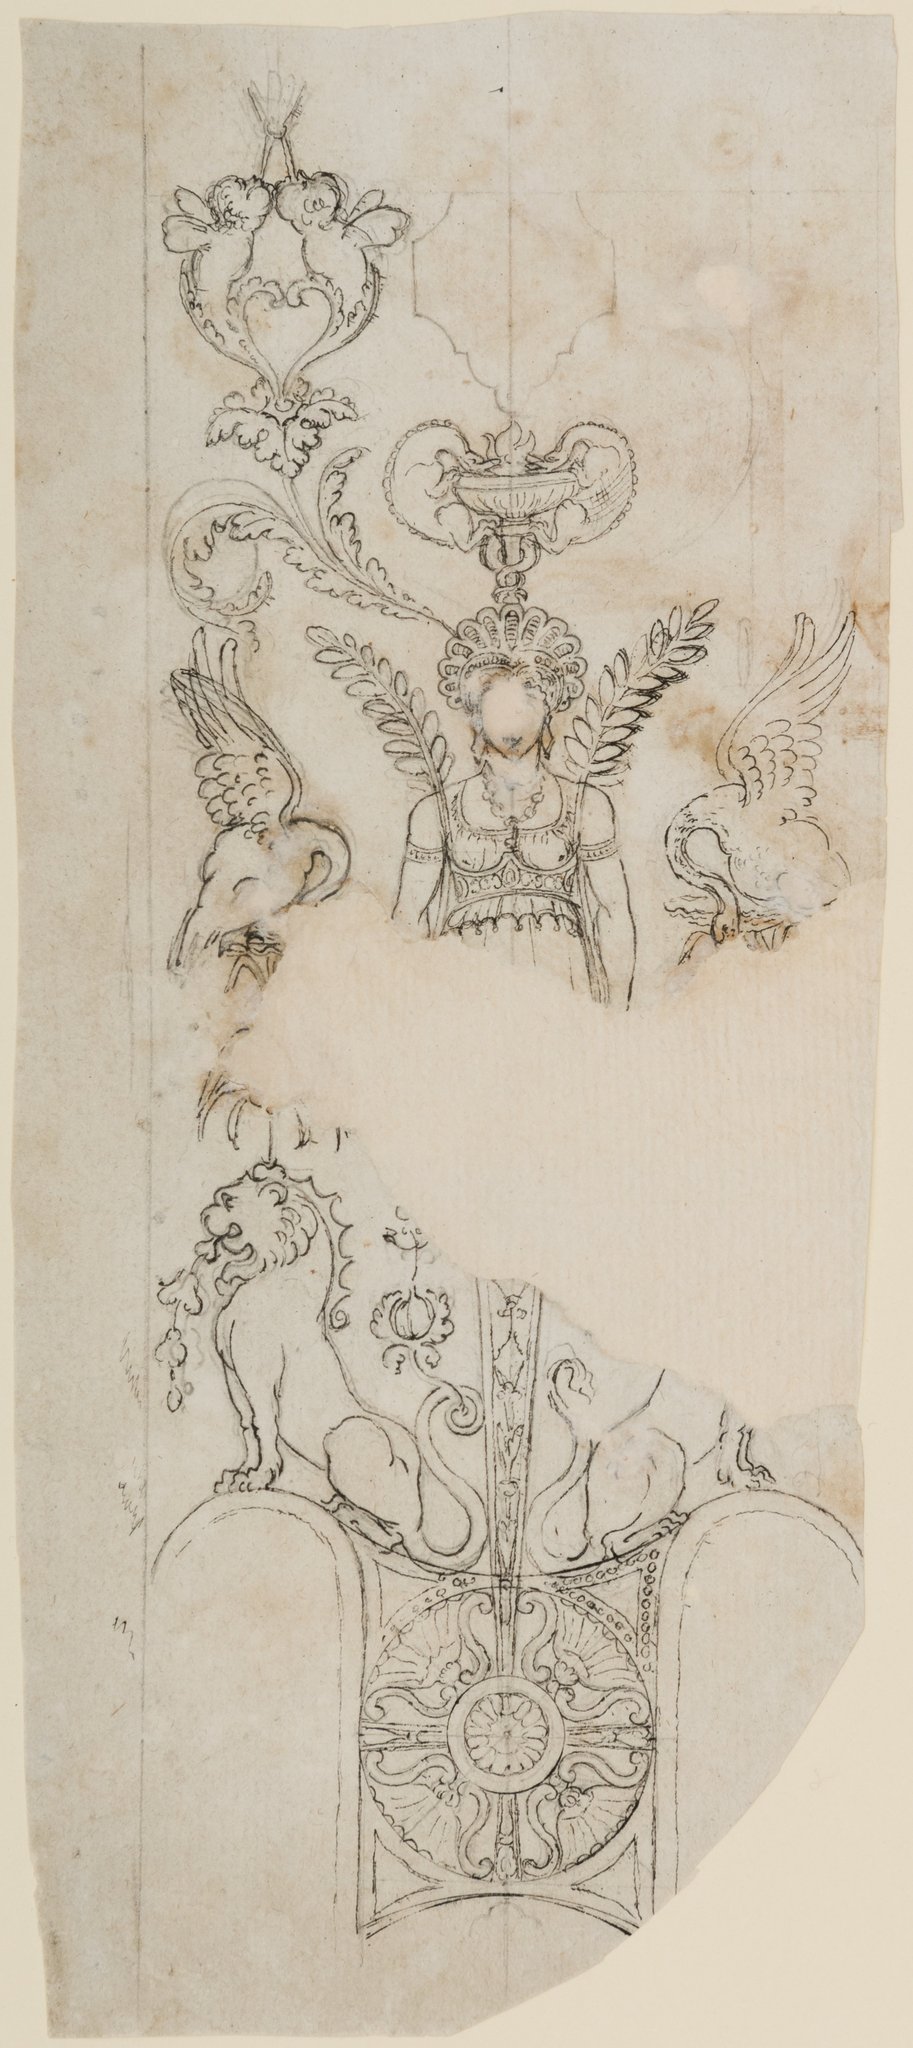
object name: drawing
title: Design for the Decoration of Firearms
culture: french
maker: nicolas noël boutet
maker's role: designer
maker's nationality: french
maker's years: 1761-1833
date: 1797-1805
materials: ink, paper, pencil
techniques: wash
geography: france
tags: ornament,swans,lions